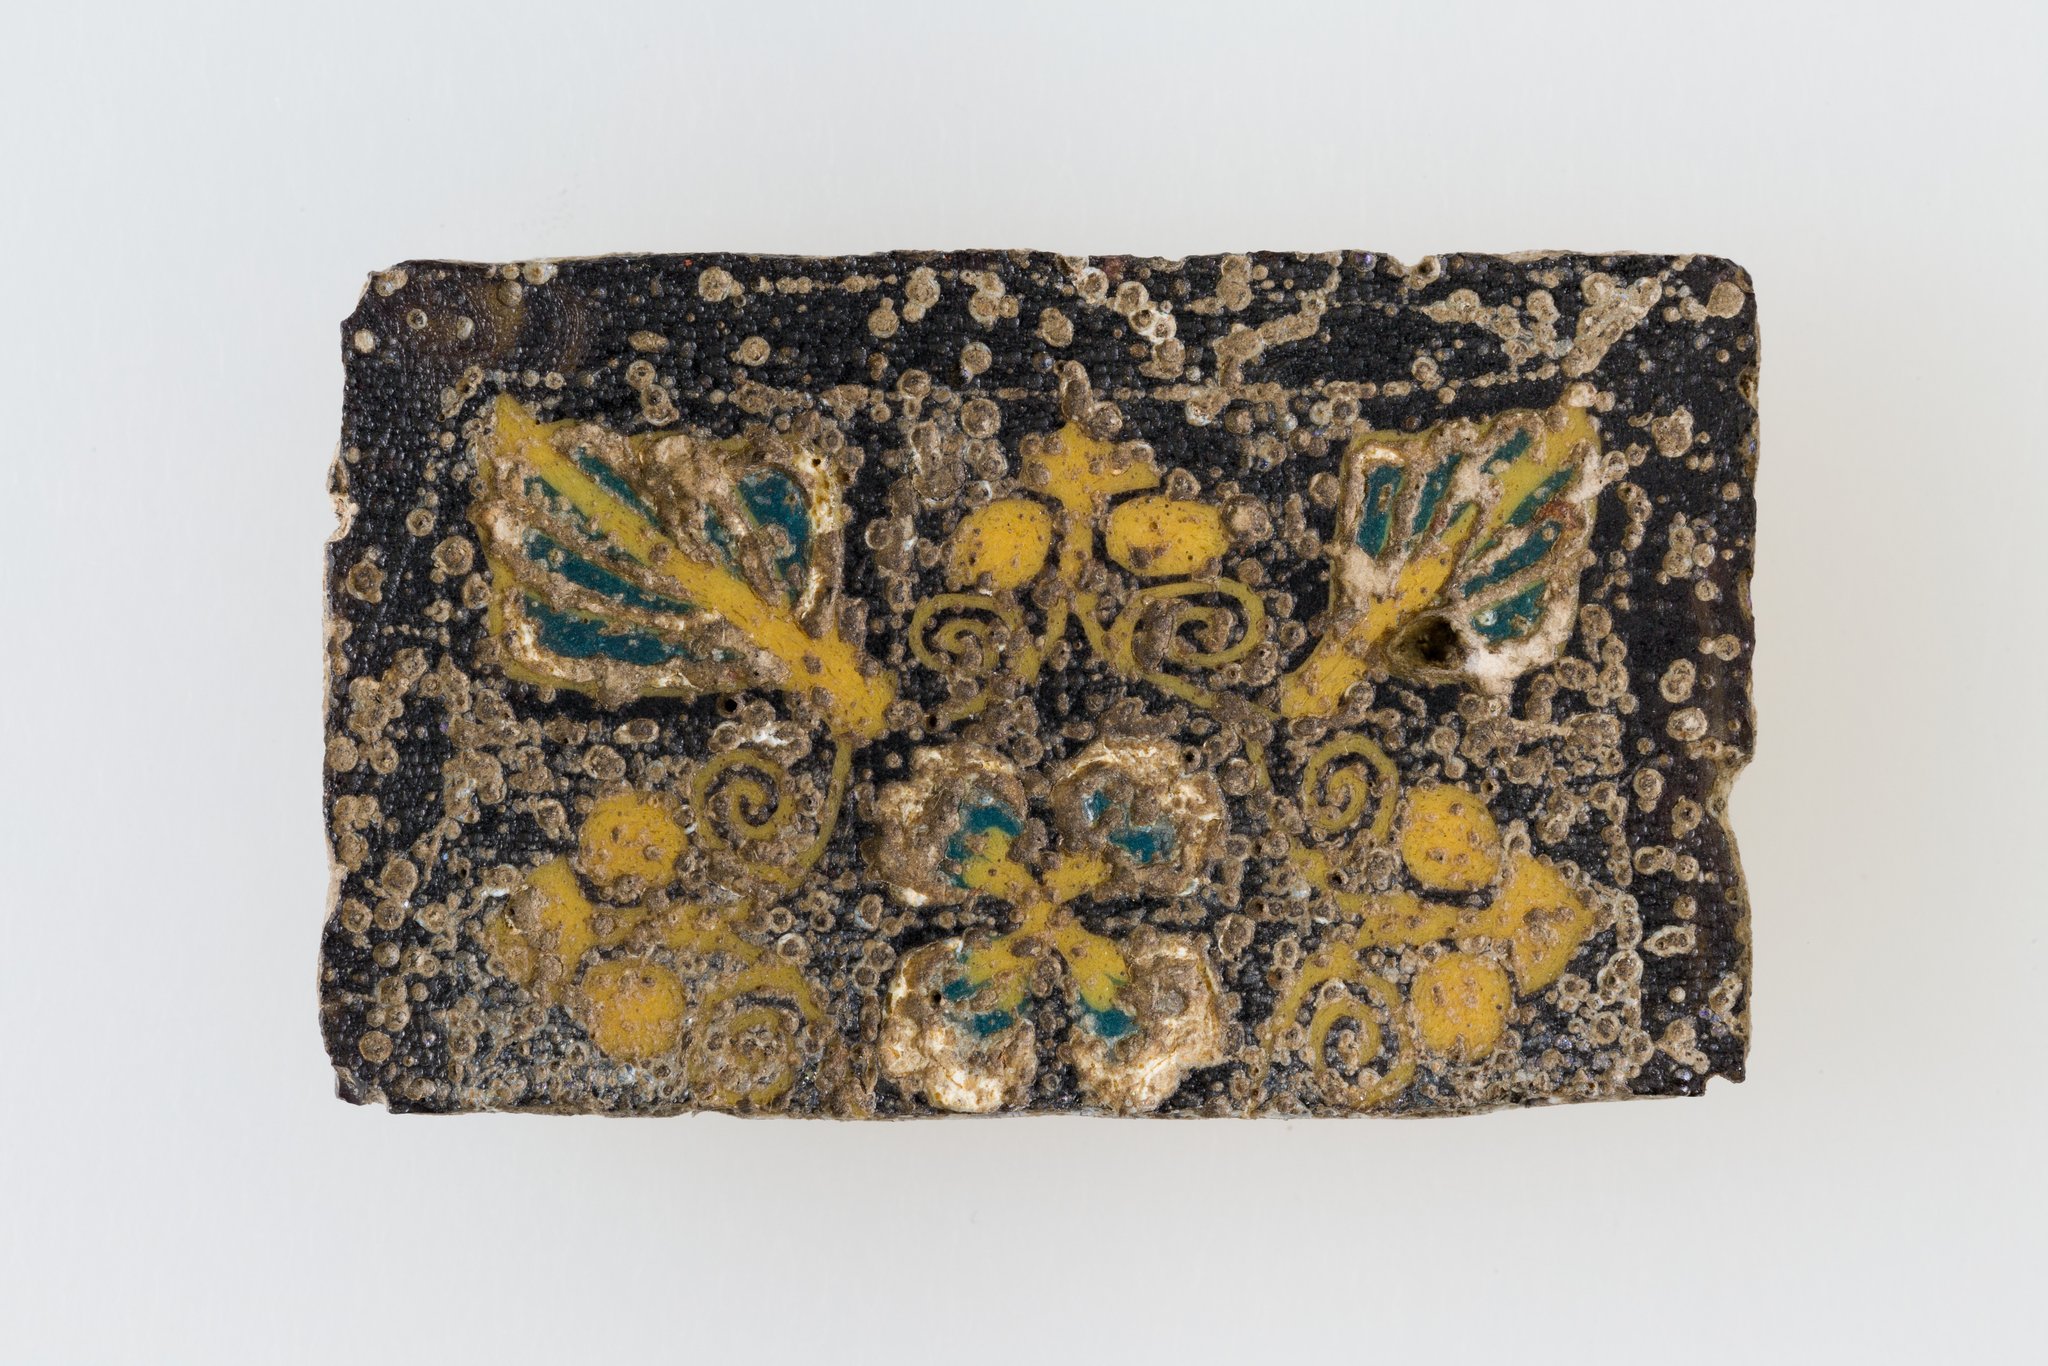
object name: inlay, palmette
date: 100 BCE-100 CE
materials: glass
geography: egypt